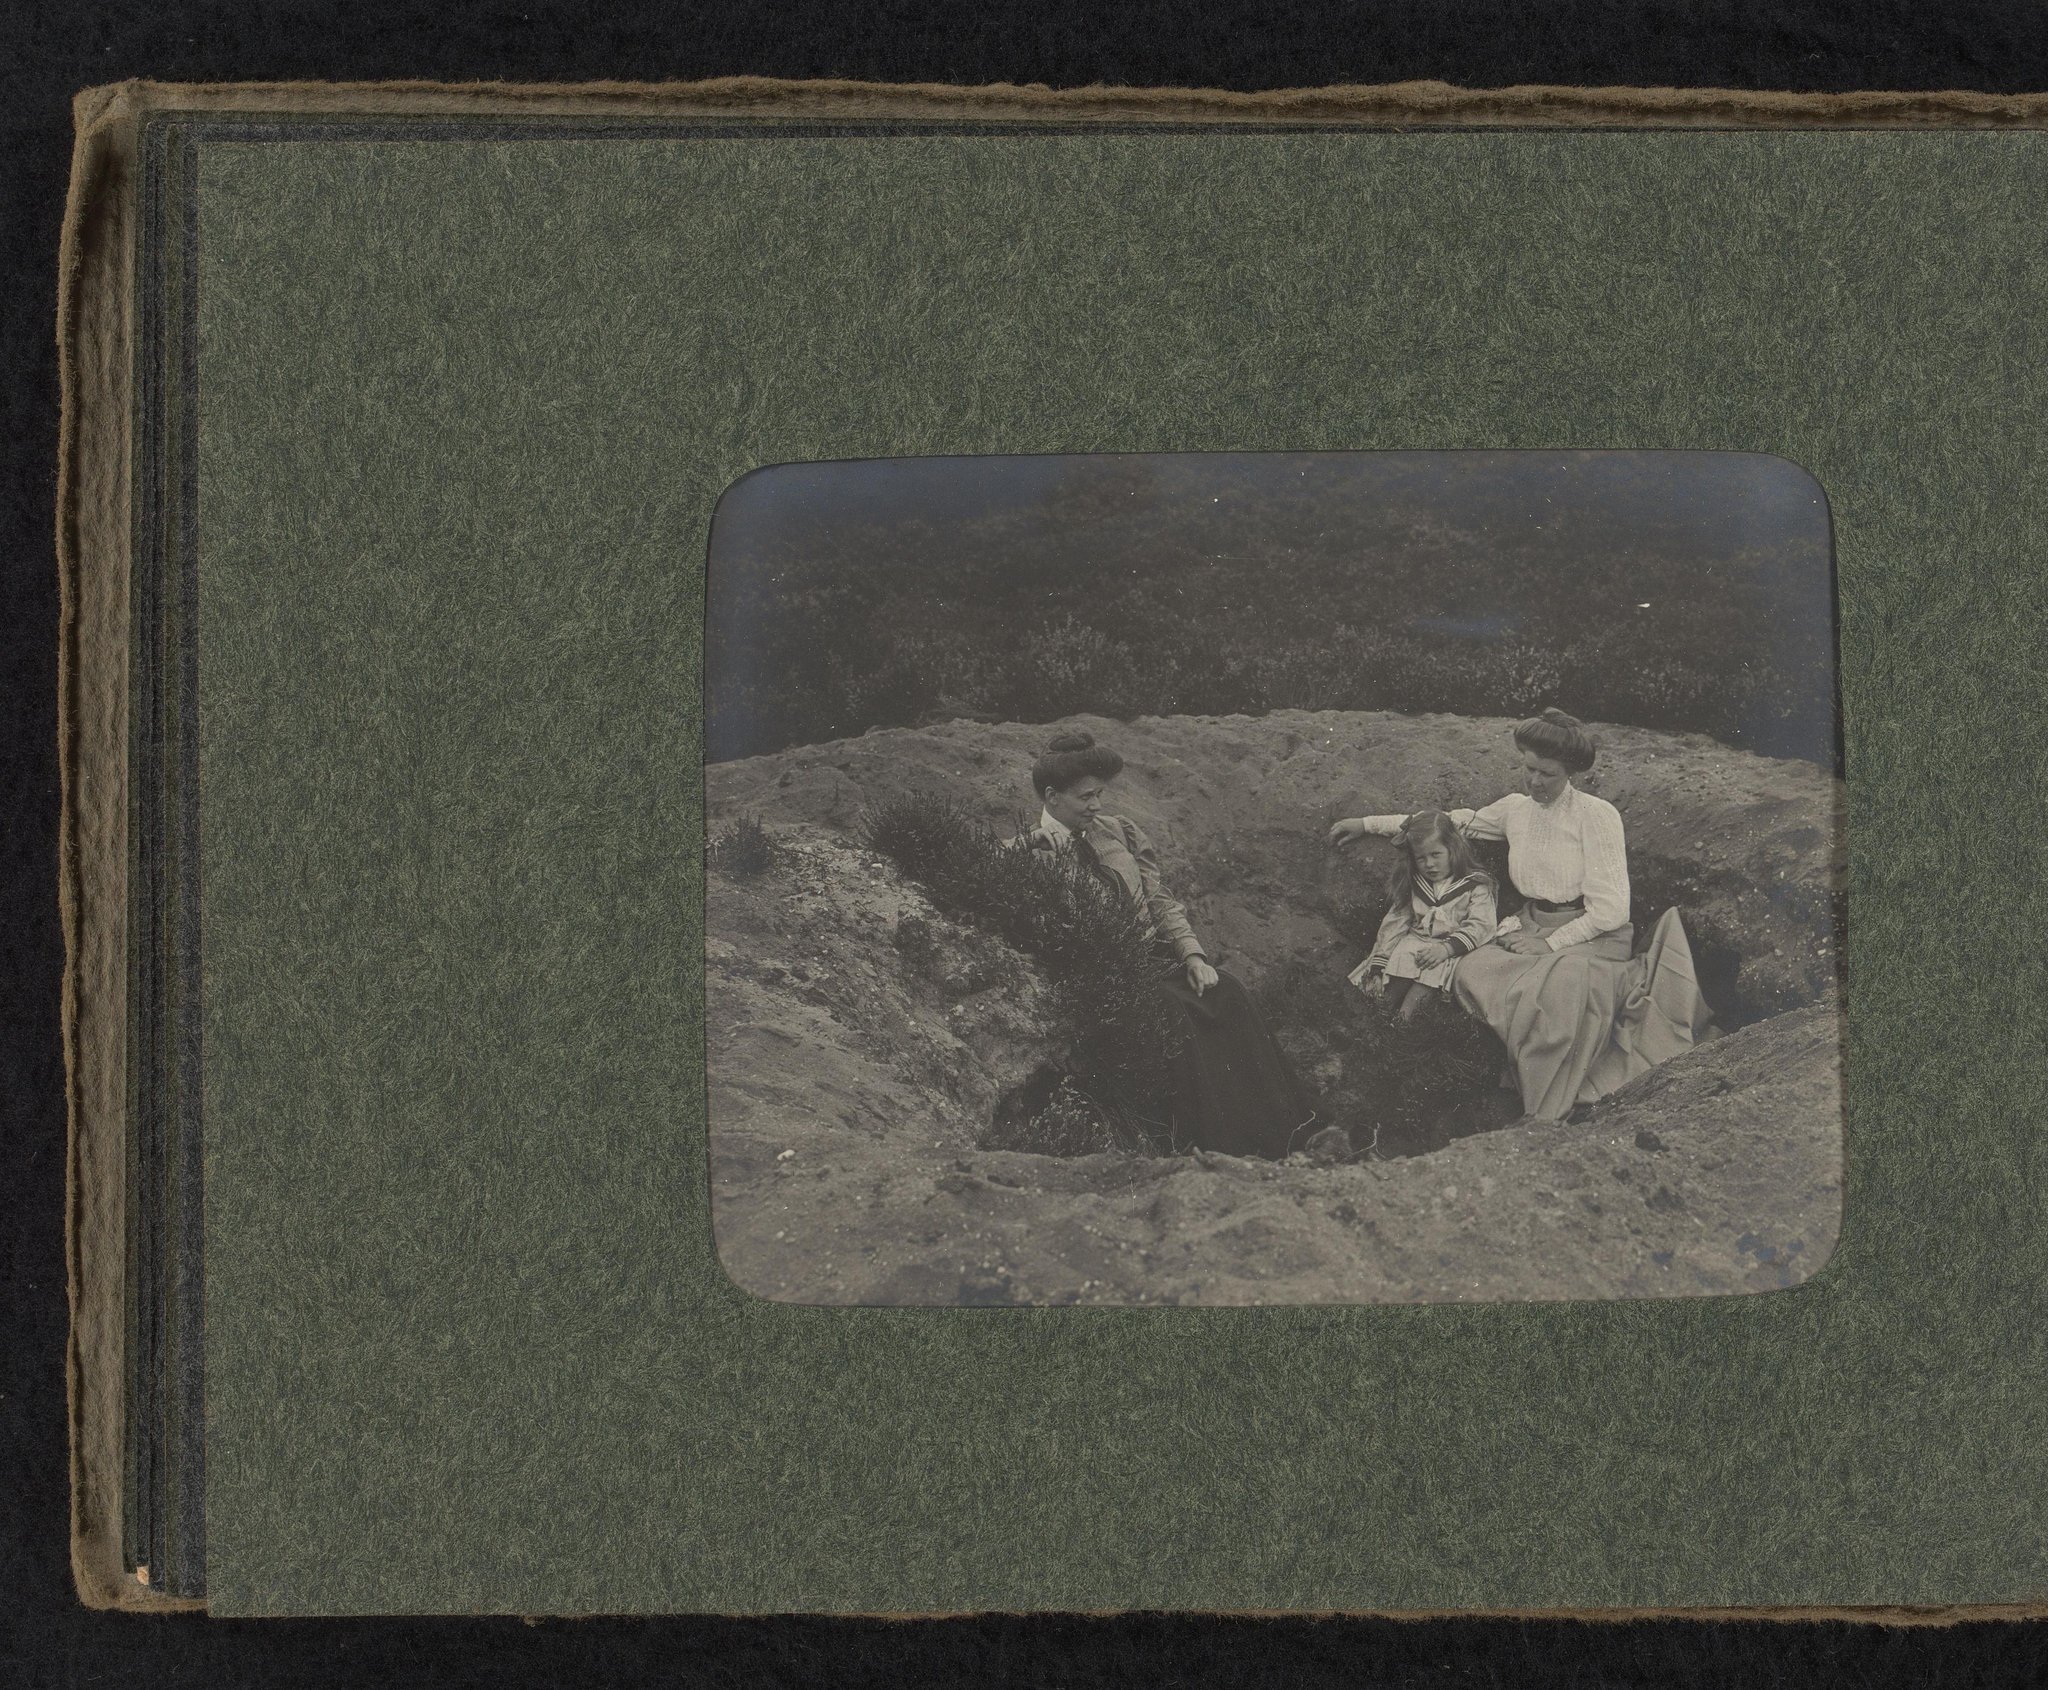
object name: photograph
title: Drie leden van de familie van den Berg, in een zandkuil op de heide in Huis ter Heide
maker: hendrik herman van den berg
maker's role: amateurfotograaf, jurist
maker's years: 1875-1944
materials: paper, cardboard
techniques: gelatin silver print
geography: huis ter heide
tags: the hague, caroline louise van den berg-van den berg, family life